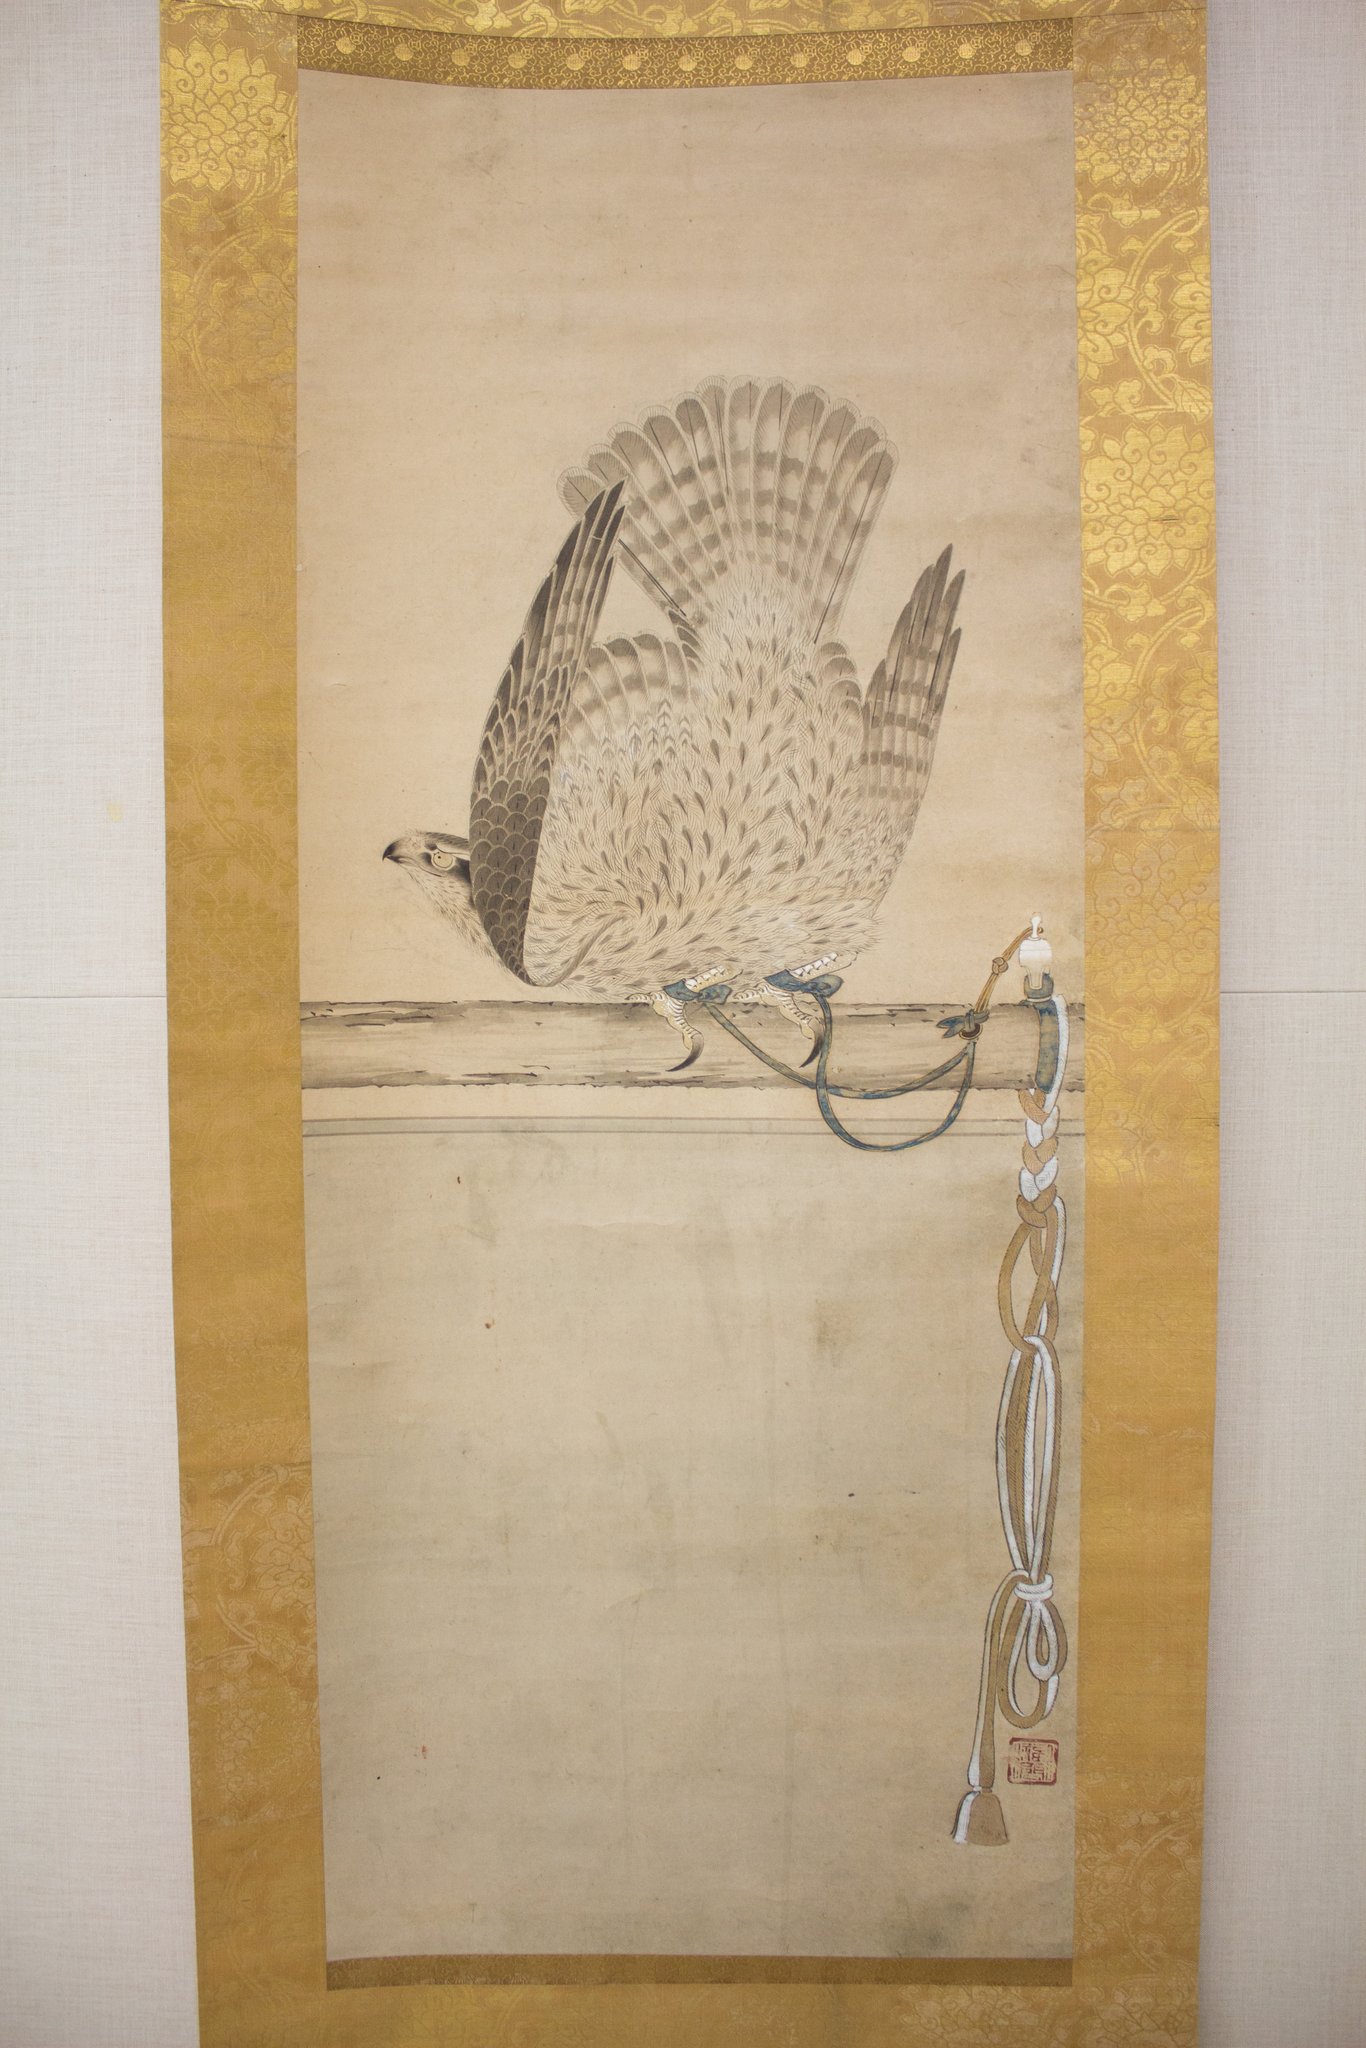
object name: hanging scroll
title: Hunting Hawk on Perch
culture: japanese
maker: soga chokuan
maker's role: artist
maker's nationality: japanese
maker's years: 1596-1615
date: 1767-1833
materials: ink, paper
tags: hawks